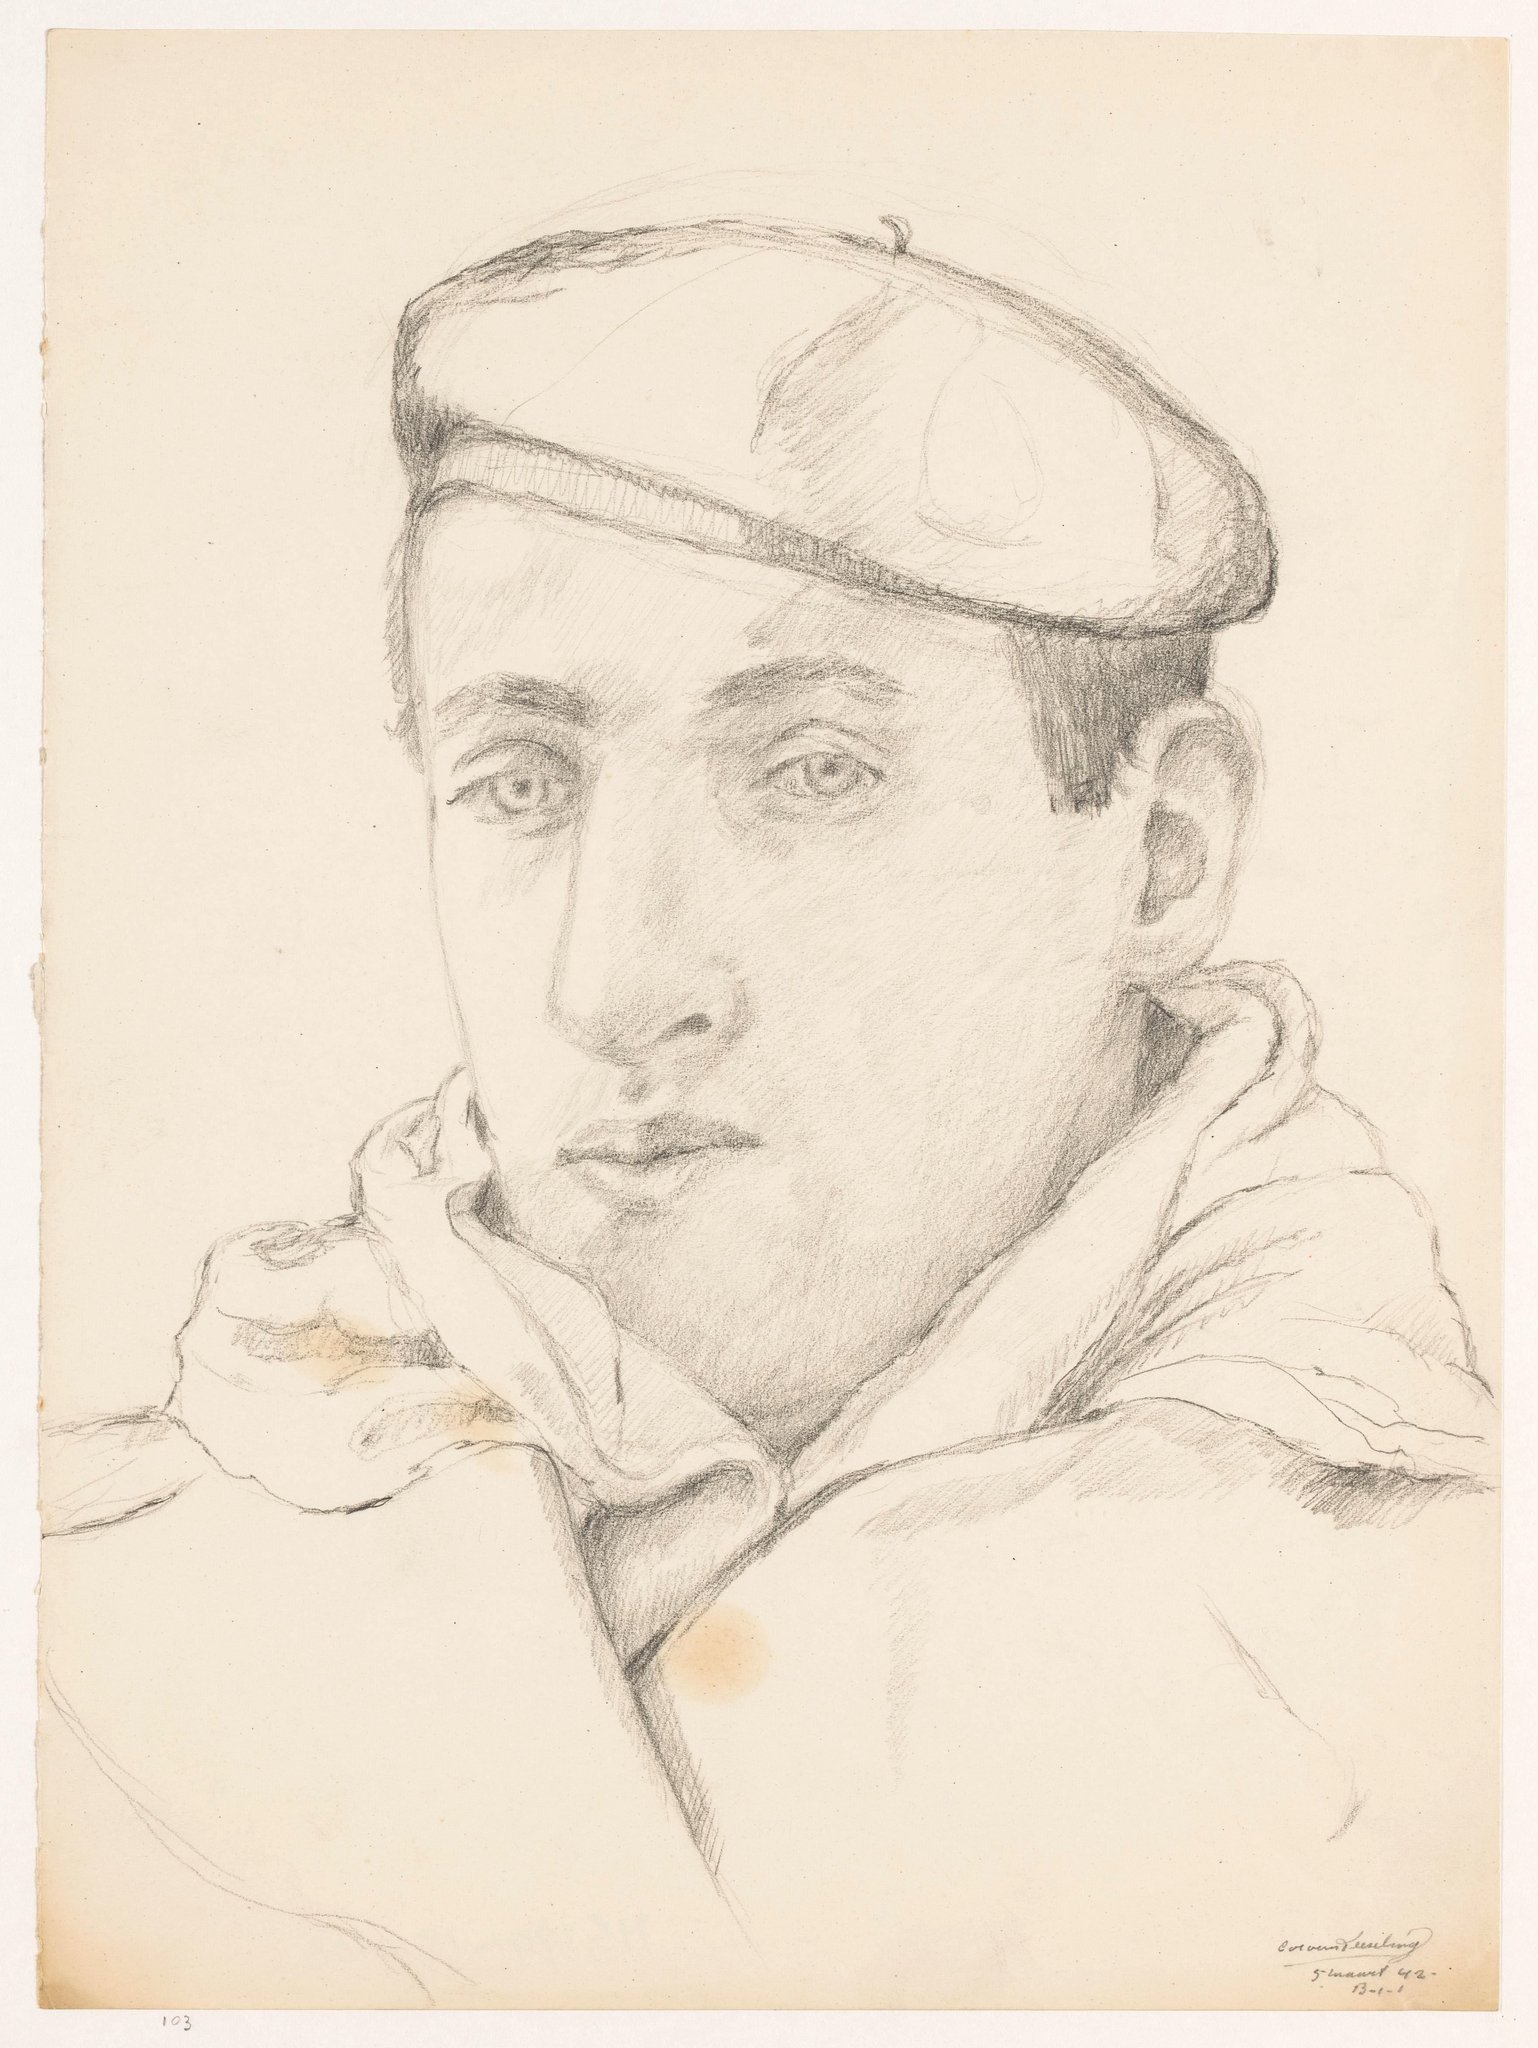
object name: drawing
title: Zelfportretten van Cor van Teeseling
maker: cor van teeseling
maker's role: draughtsman, sculptor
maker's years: 1915-1942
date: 1942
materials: paper, pencil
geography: weteringschans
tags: amsterdam, draughtsman, sculptor, cor van teeseling, historical persons, prisoner in cell or locked place, portrait, self-portrait of draughtsman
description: Zelfportret van Cor van Teeseling met pet: B-1-1, 5 maart. Zelfportret van Cor van Teeseling driekwart, naar links kijkend.